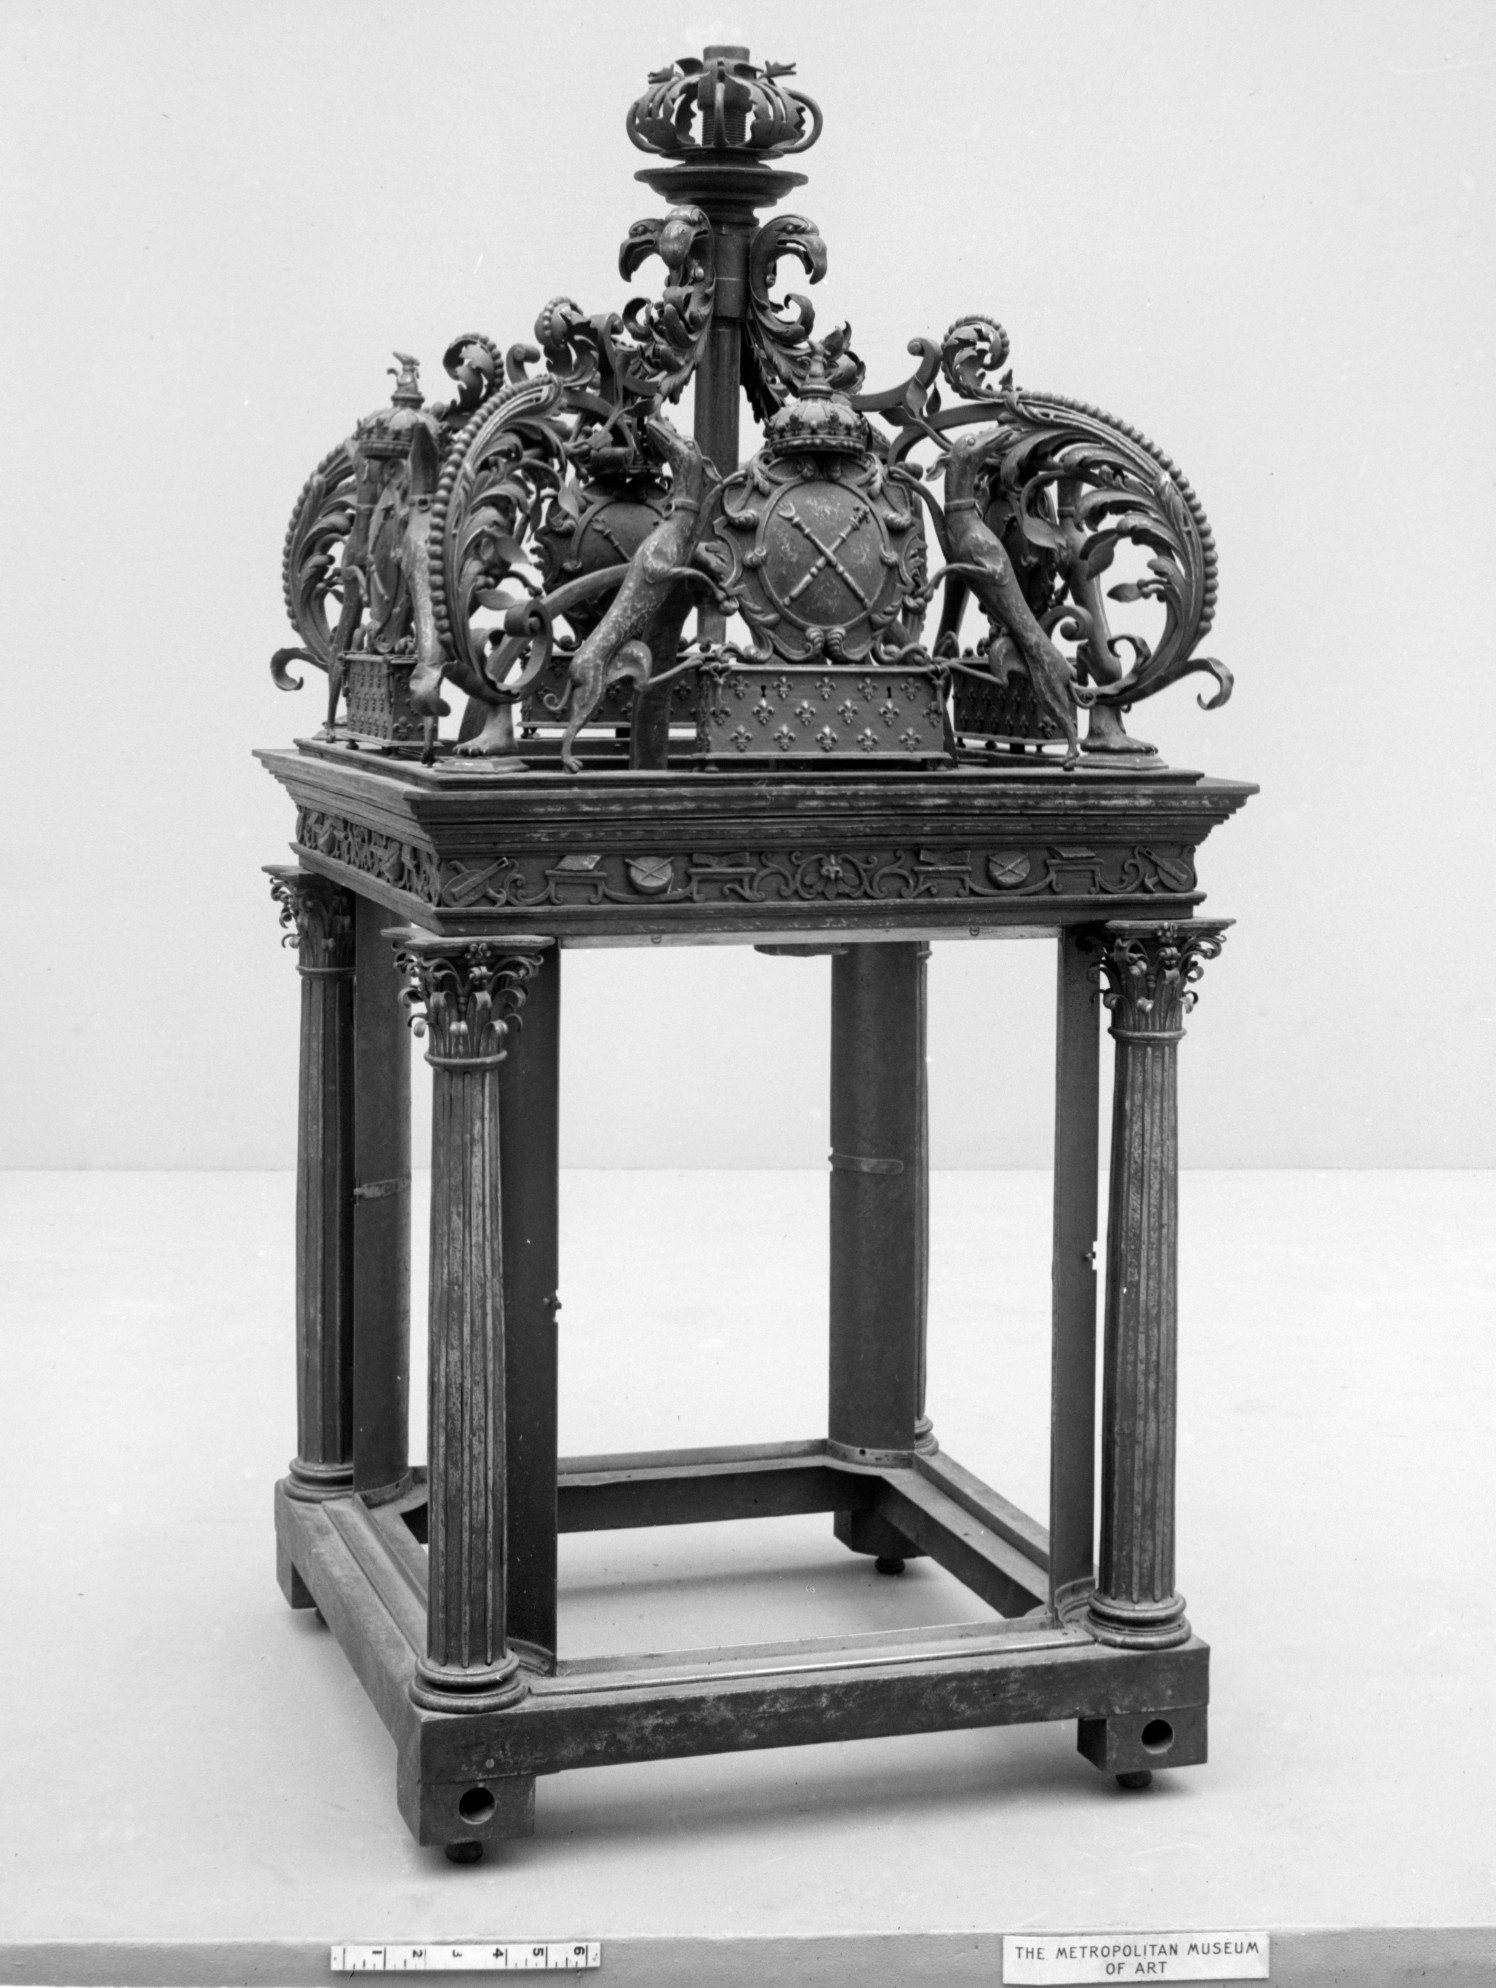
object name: lantern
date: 1851-1900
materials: iron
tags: dogs,coat of arms